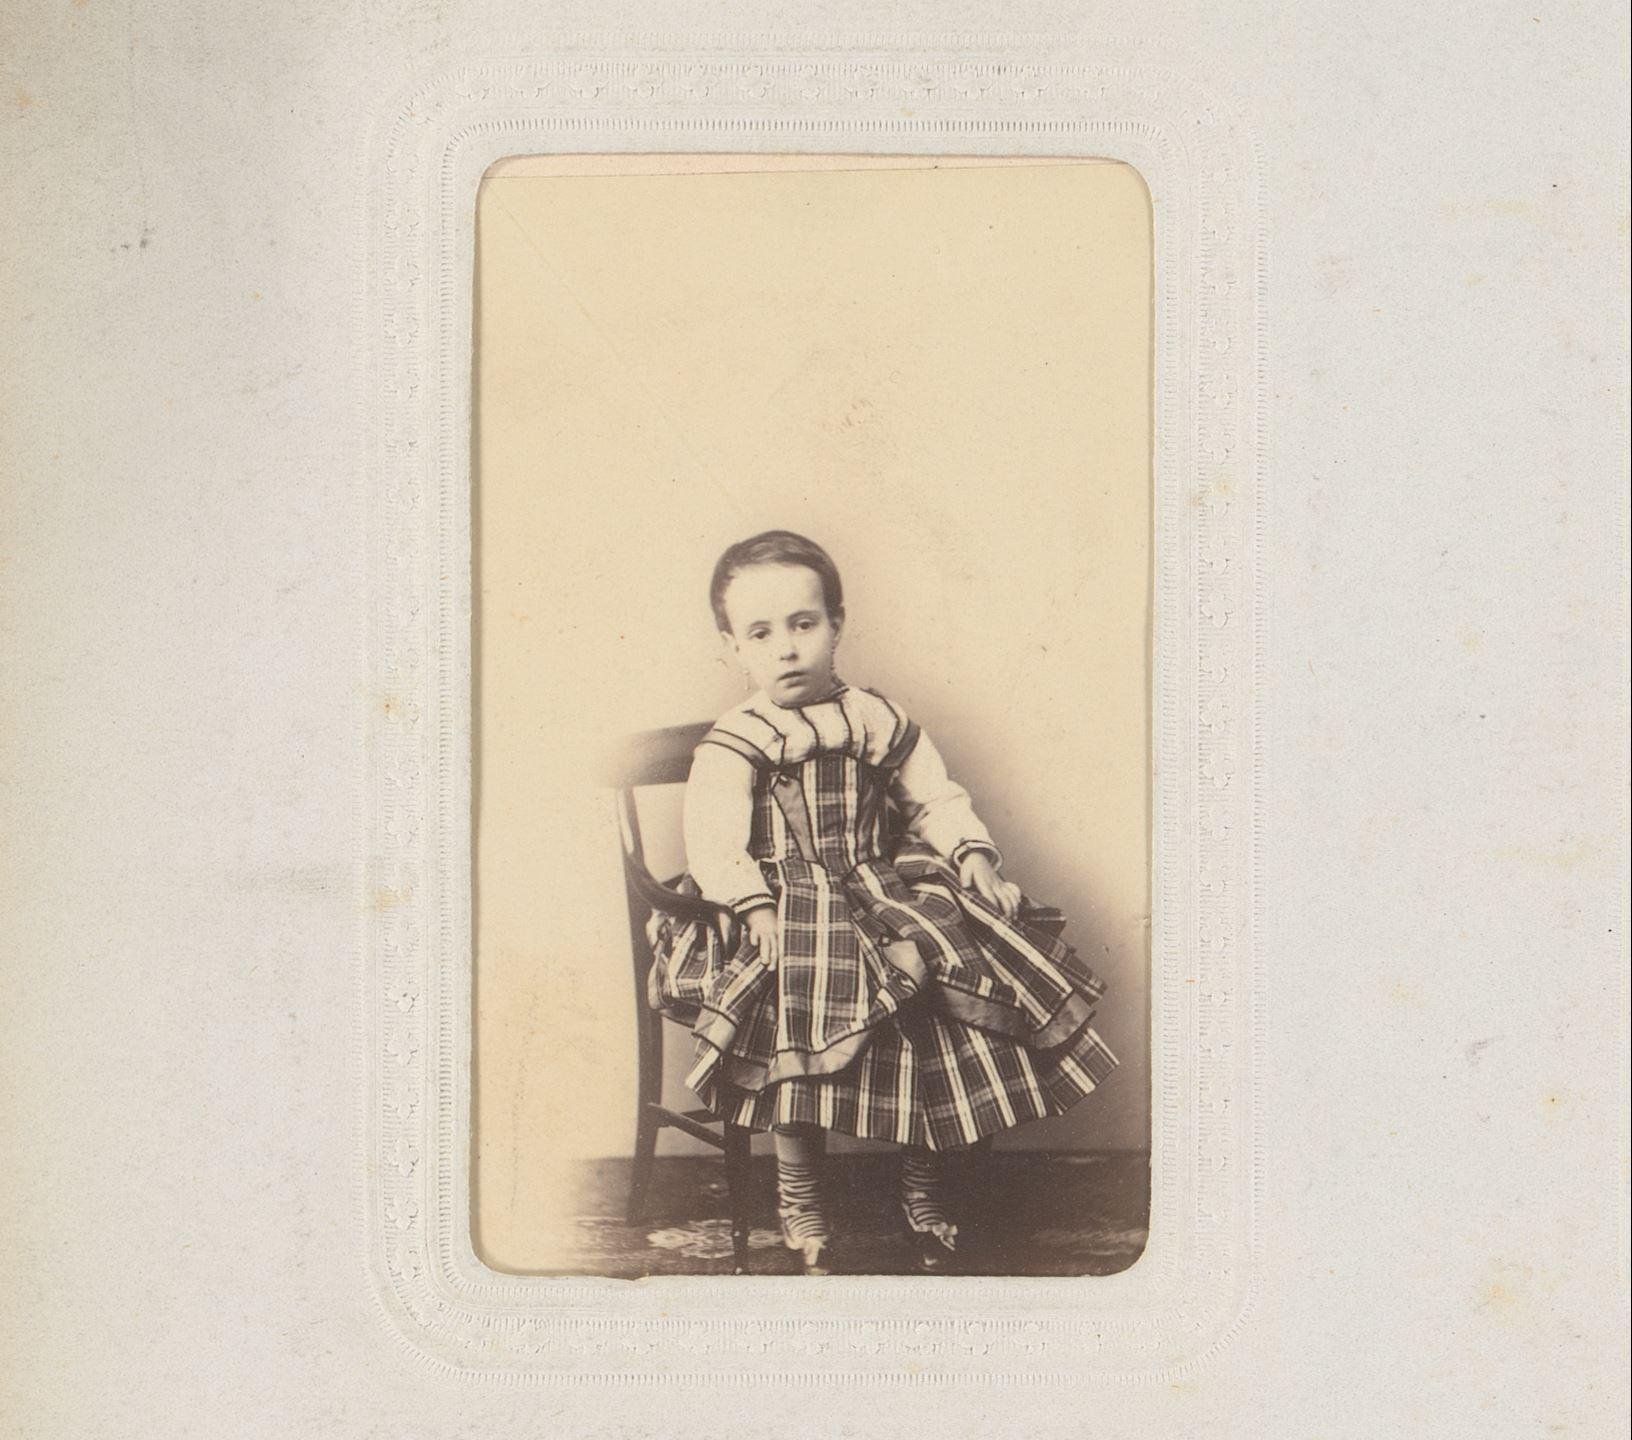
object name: album leaf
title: Portret van een meisje, zittend op een stoel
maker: alphonse bernoud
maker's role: fotograaf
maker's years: 1820-1889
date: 1866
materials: cardboard, photographic support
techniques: albumen print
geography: italy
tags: sitting figure - aa - female human figure, historical persons - bb - woman, girl (child between toddler and youth)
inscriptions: annotation: ‘[...] 1866]’, inscription: ‘Alphonse Bernoud/ Médaille et Breveté, s.g.d.g./ Photographe (...) Florenc/ Via dell'Orivolo, 51/ Livourne/ Via Vittoro Emanuele, 71/ Naples/ Toledo, 256 Palazzo Berio’